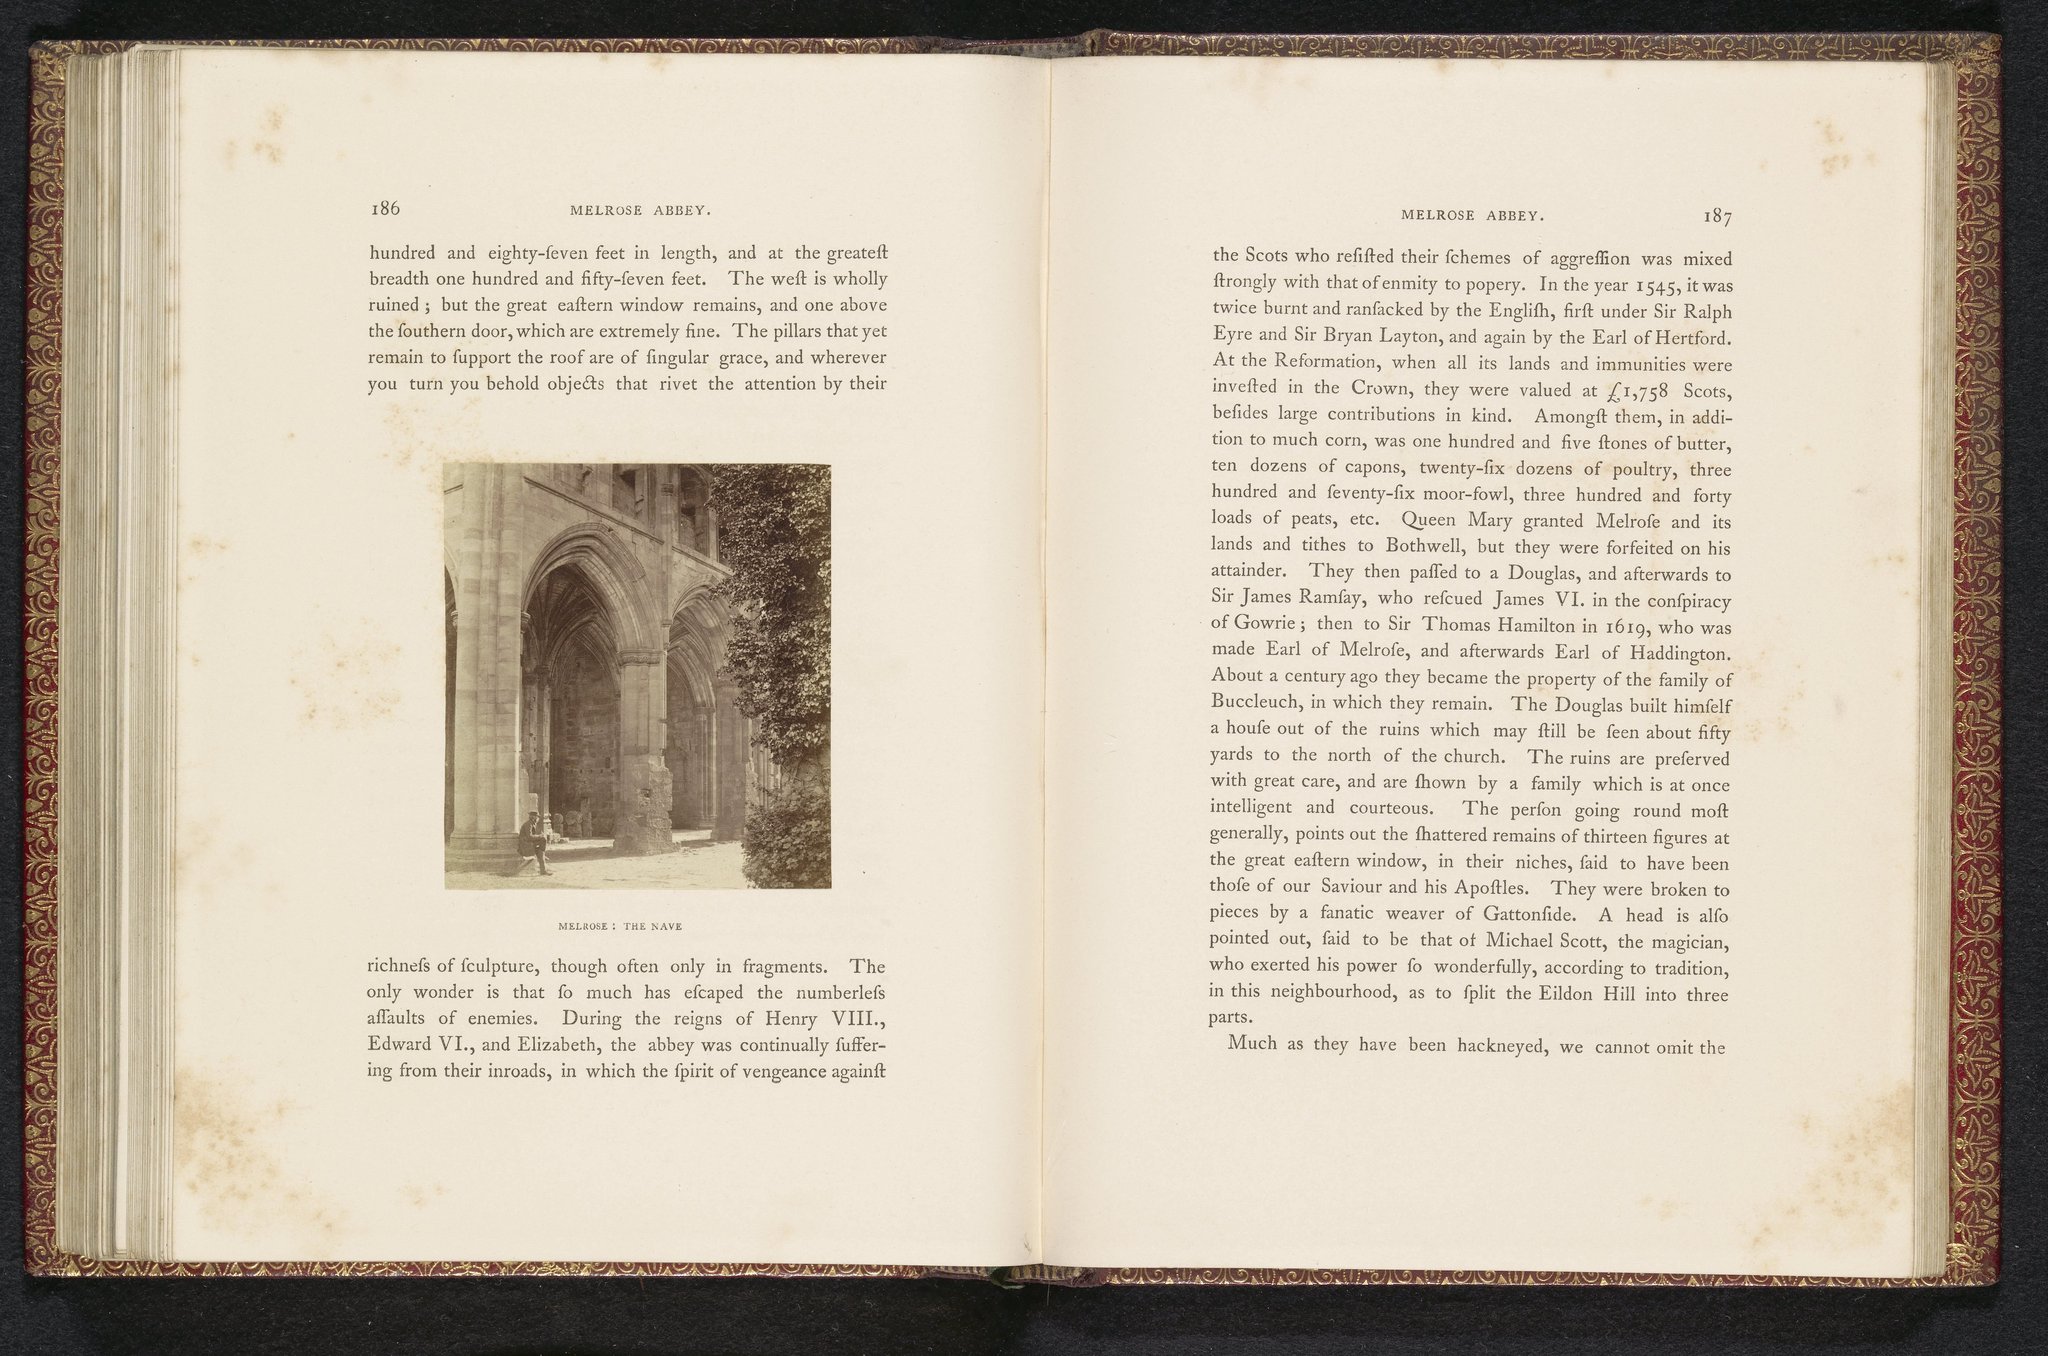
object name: photograph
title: Exterieur van het schip van de Melrose Abbey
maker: george washington wilson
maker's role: publisher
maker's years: 1823-1893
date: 1852-1862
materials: photographic support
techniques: albumen print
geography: melrose abbey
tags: ruin of church, monastery, etc., parts of church interior: nave